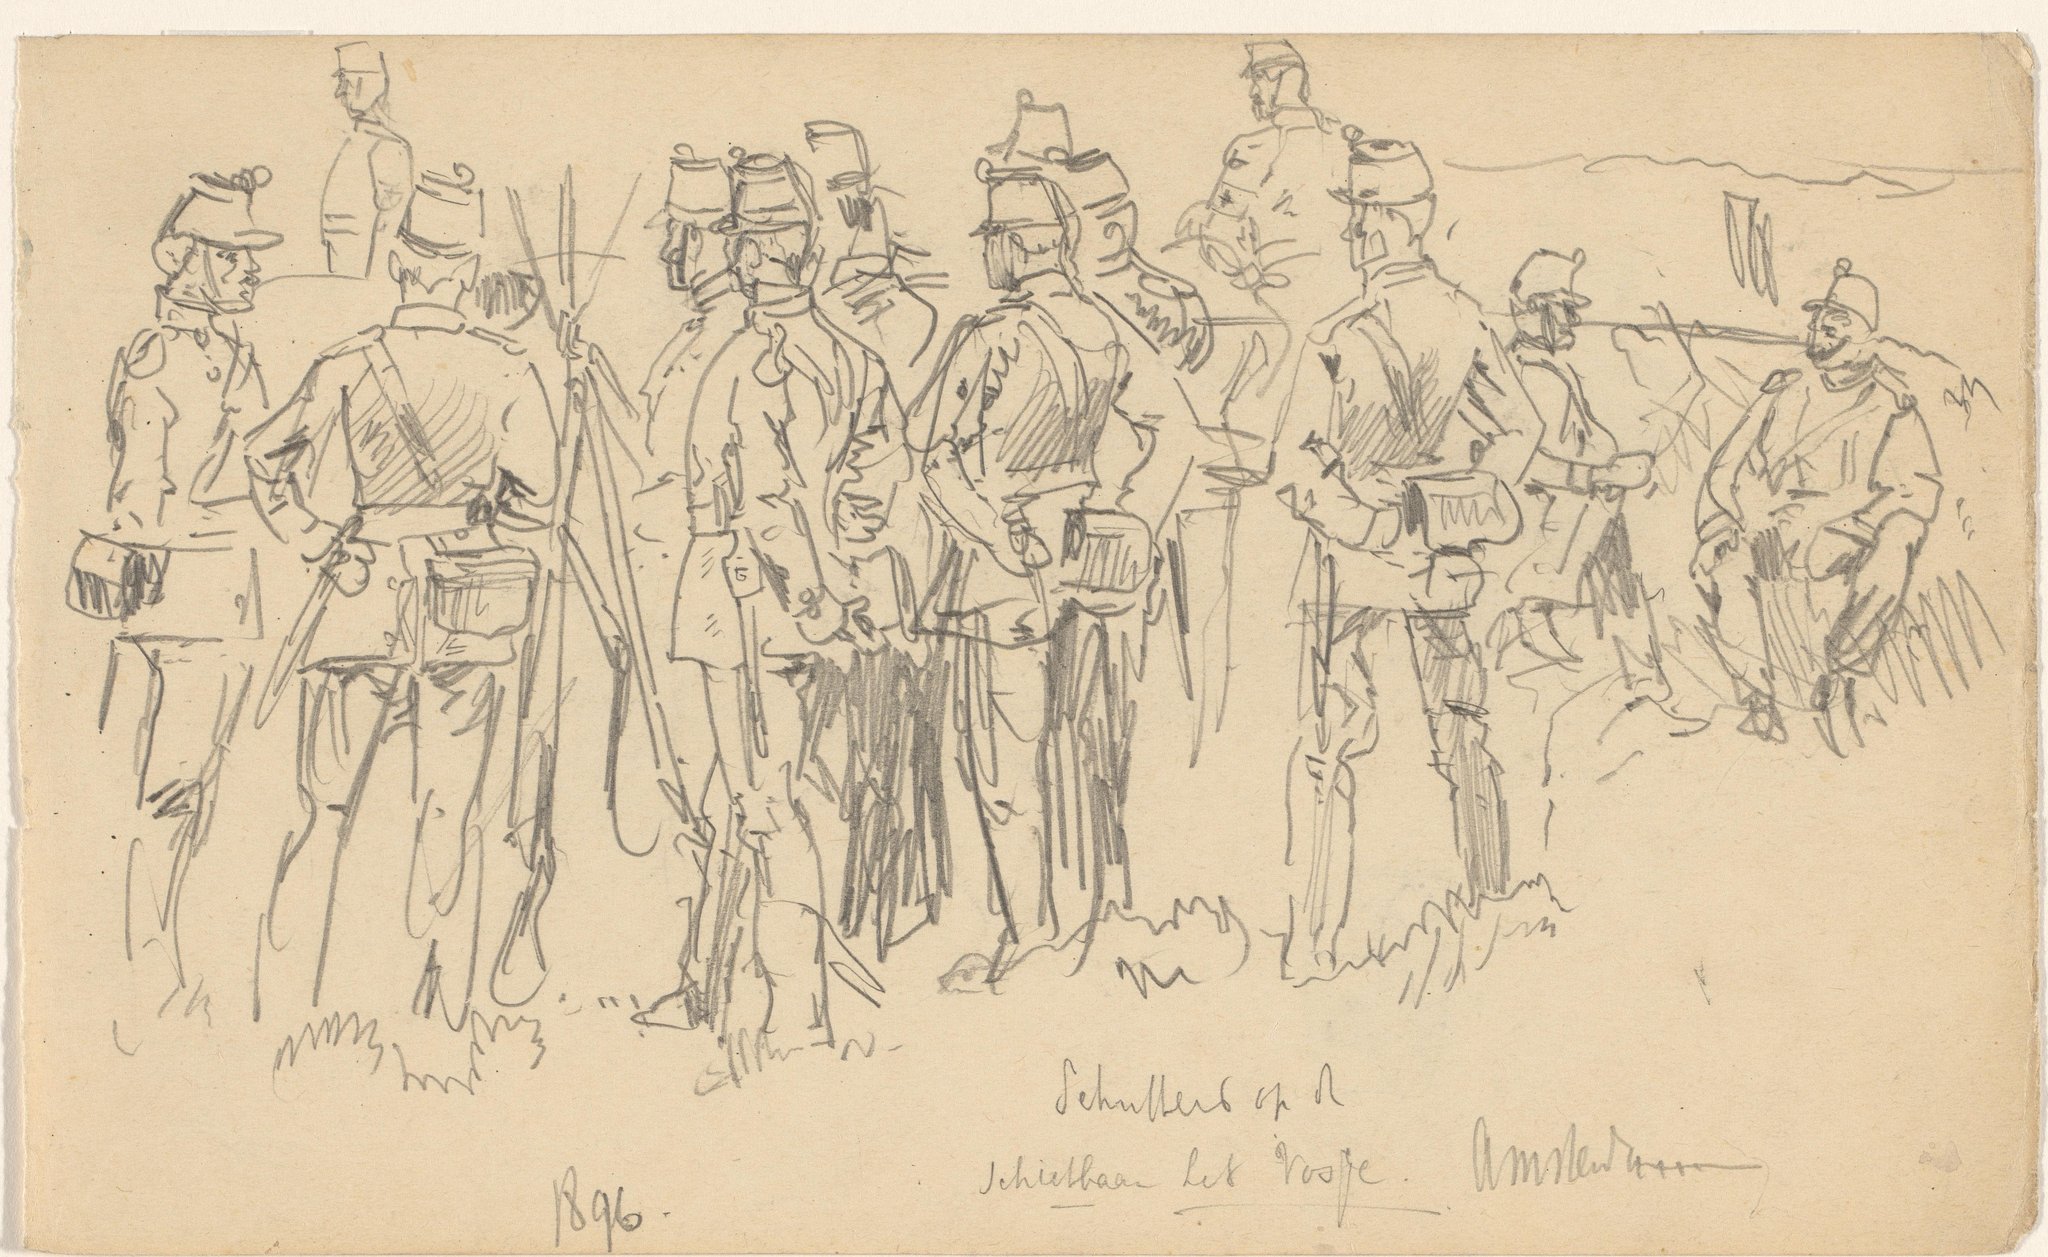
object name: drawing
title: Schutters op schietbaan het Vosje te Amsterdam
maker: jan hoynck van papendrecht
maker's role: draughtsman, painter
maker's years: 1858-1933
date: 1896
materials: paper, pencil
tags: firearms (+ handling of weapons), handling of weapons ~ military training, (military) uniforms, amsterdam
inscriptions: annotation: ‘schutters op de/ schietbaan het Vosje Amsterdam’